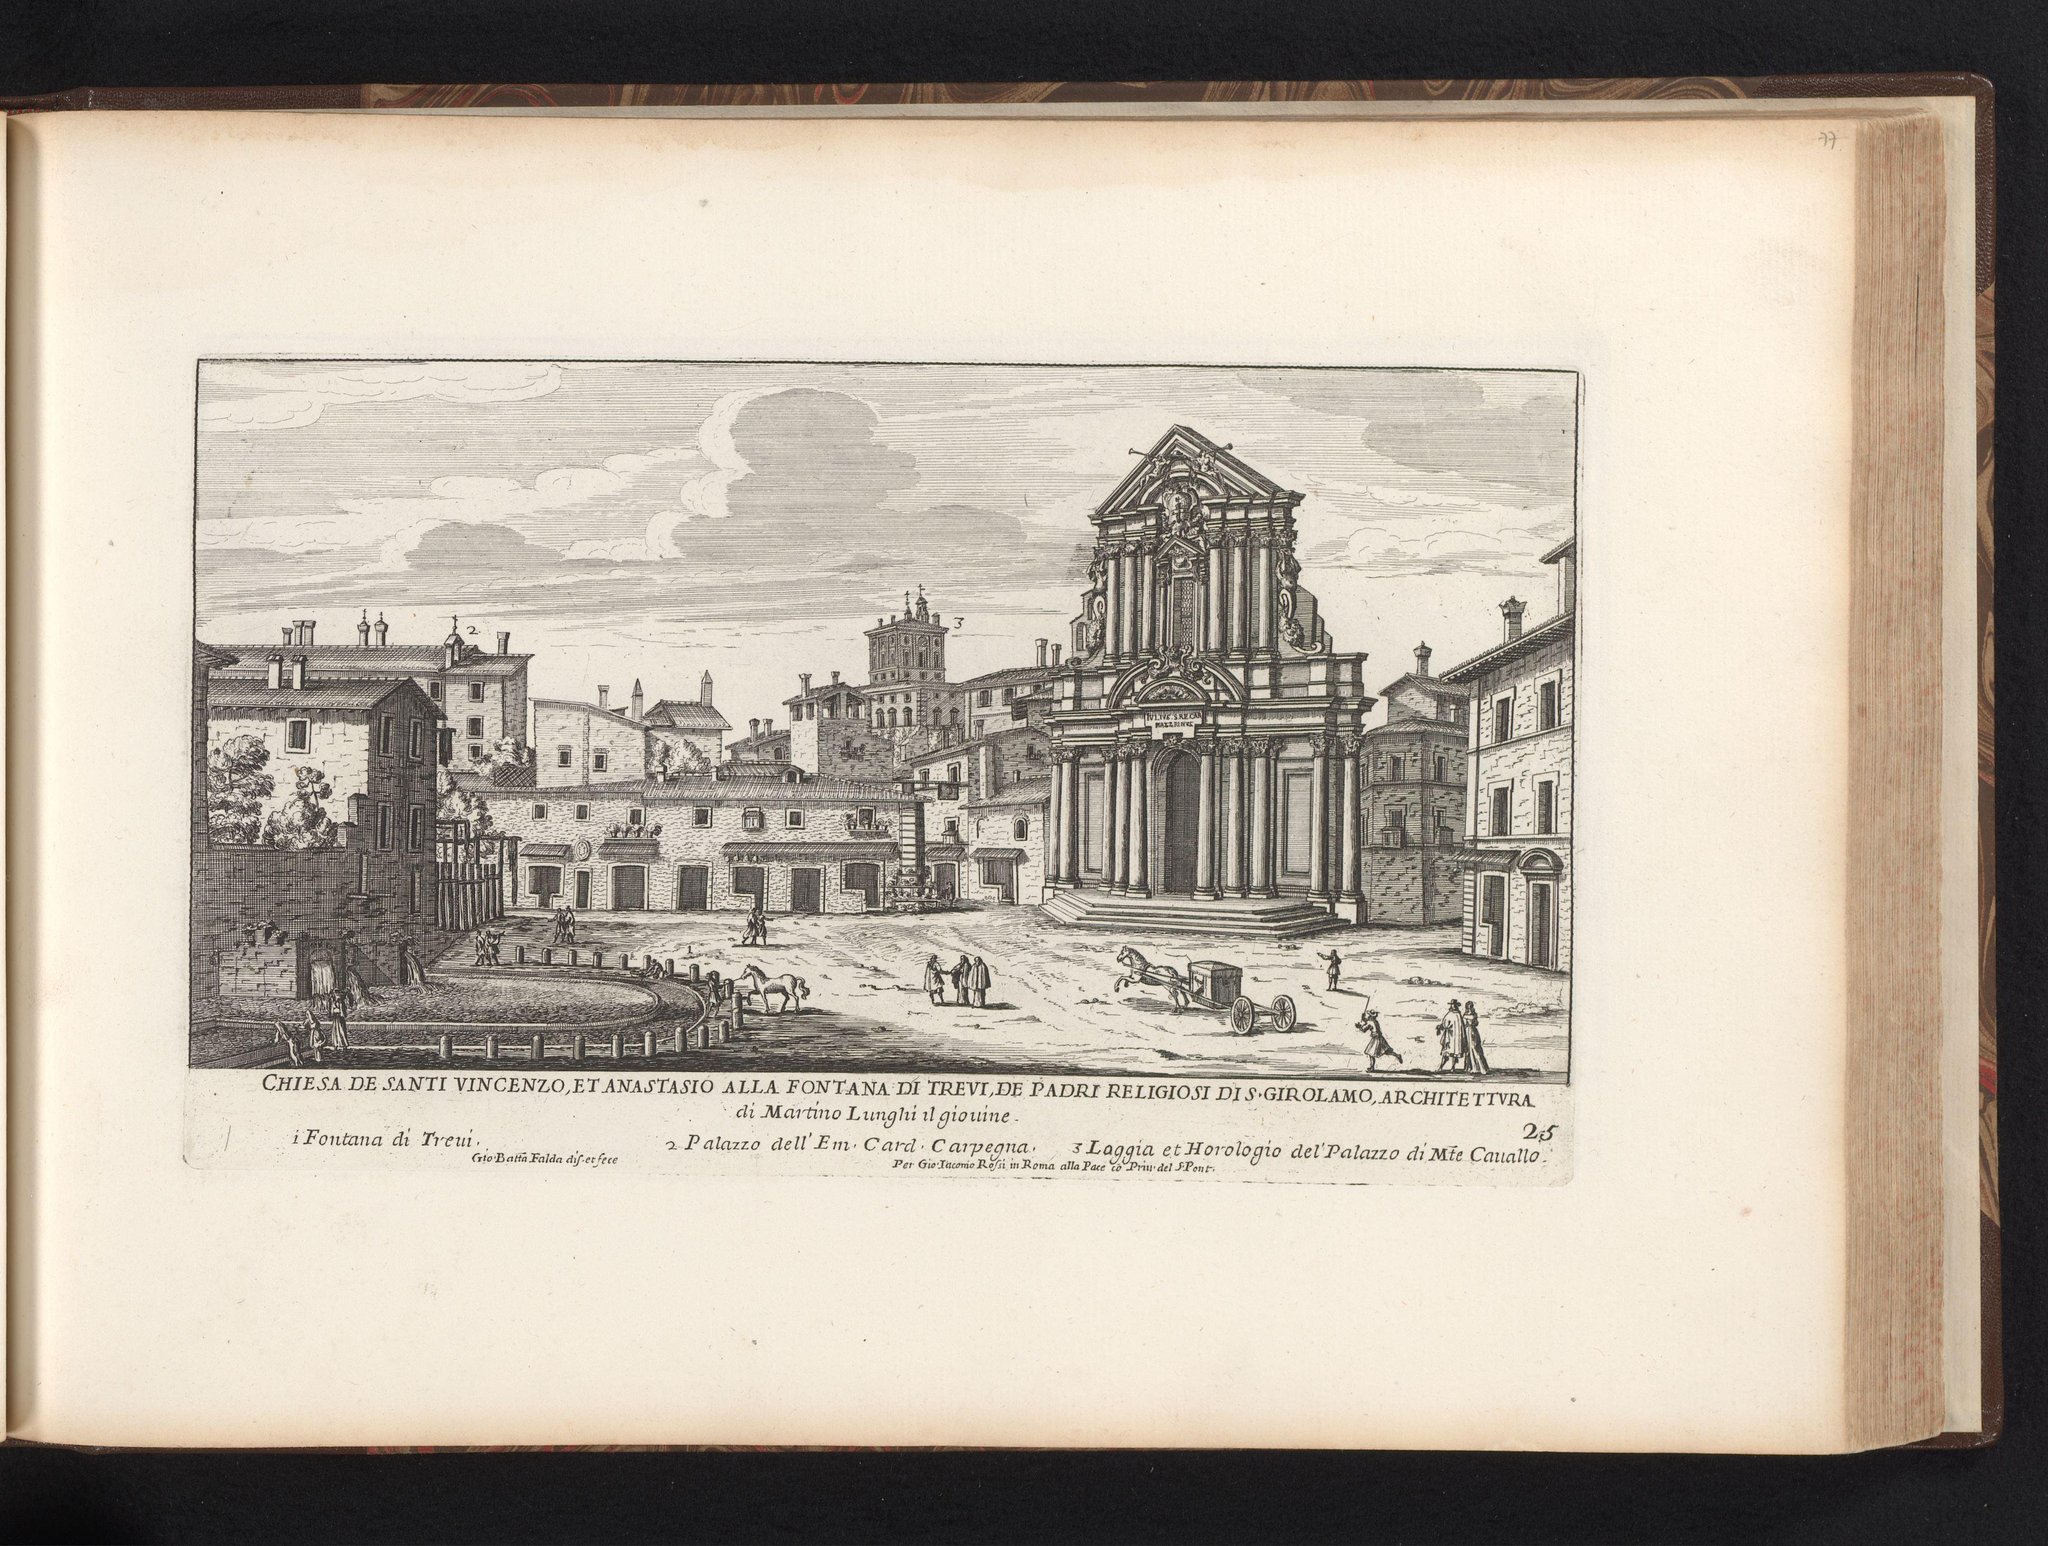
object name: album leaf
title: Chiesa dei Santi Vincenzo e Anastasio a Trevi te Rome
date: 1669-1670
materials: paper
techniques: etching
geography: rome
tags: city-view, and landscape with man-made constructions, church (exterior)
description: Deze titelprent maakt deel uit van een reeks van 38 prenten met voorstellingen van kerken in Rome. Samen met vier andere reeksen vormt het de grote reeks: 'Il nuovo teatro di Roma moderna'.